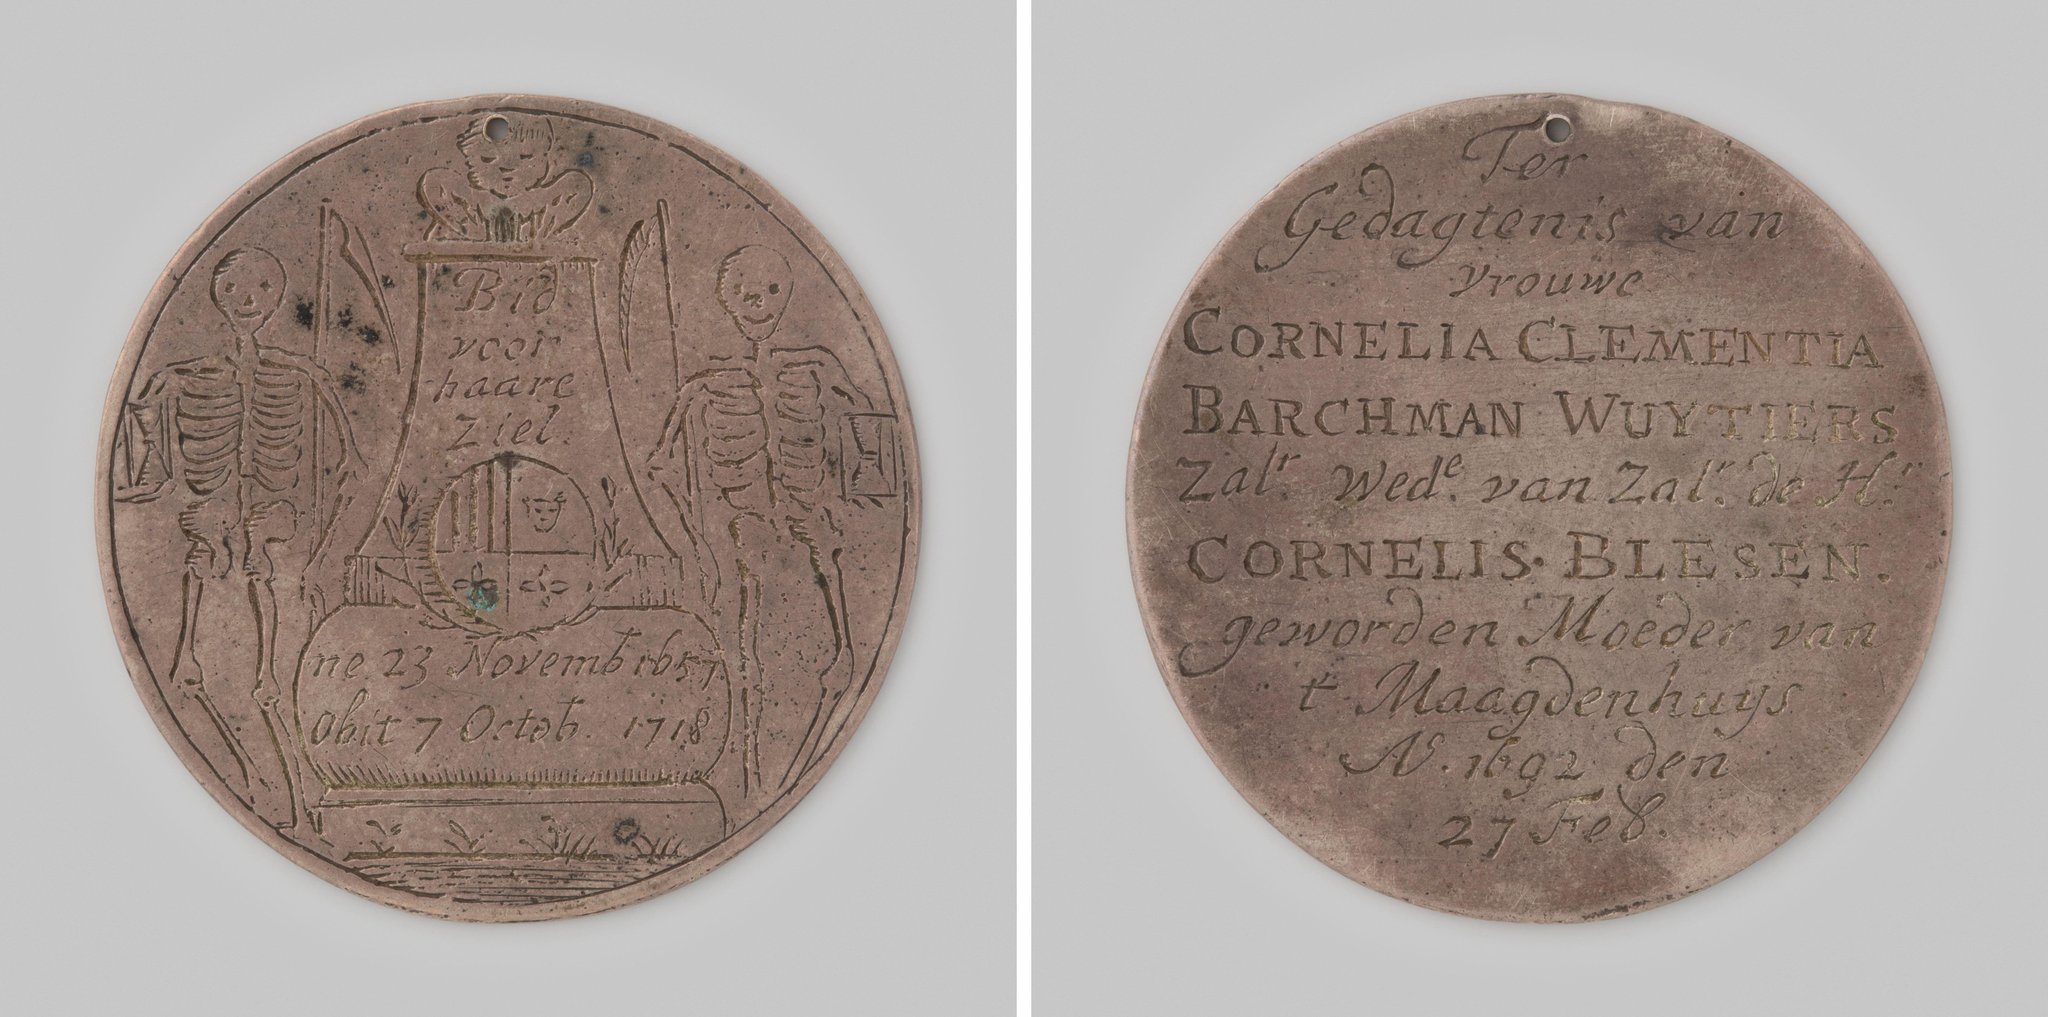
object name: history medal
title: Overlijden van Cornelia Barchman Wuytiers 1718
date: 1718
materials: silver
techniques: engraving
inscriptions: inscription: ‘ne 23 novemb' 1657 / obit 7 octob' 1718’, inscription: ‘Bid / voor / haare / ziel.’, inscription: ‘Ter / Gedagtenis van / vrouwe / CORNELIA CLEMENTIA / BARCHMAN WUYTIERS / zal'r wed'e van zal'r de H: / CORNELIS. BLESEN. / geworden Moeder van / 't Maagdenhuys / A° 1692 den / 27 feb.’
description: Ronde gegraveerde plaat zilver met klein draaggat, op de voorzijde een grafmonument, waarop een rond familiewapenschild en twee opschriften, tussen twee skeletten met zandloper en zeis, op de keerzijde elf regels tekst.